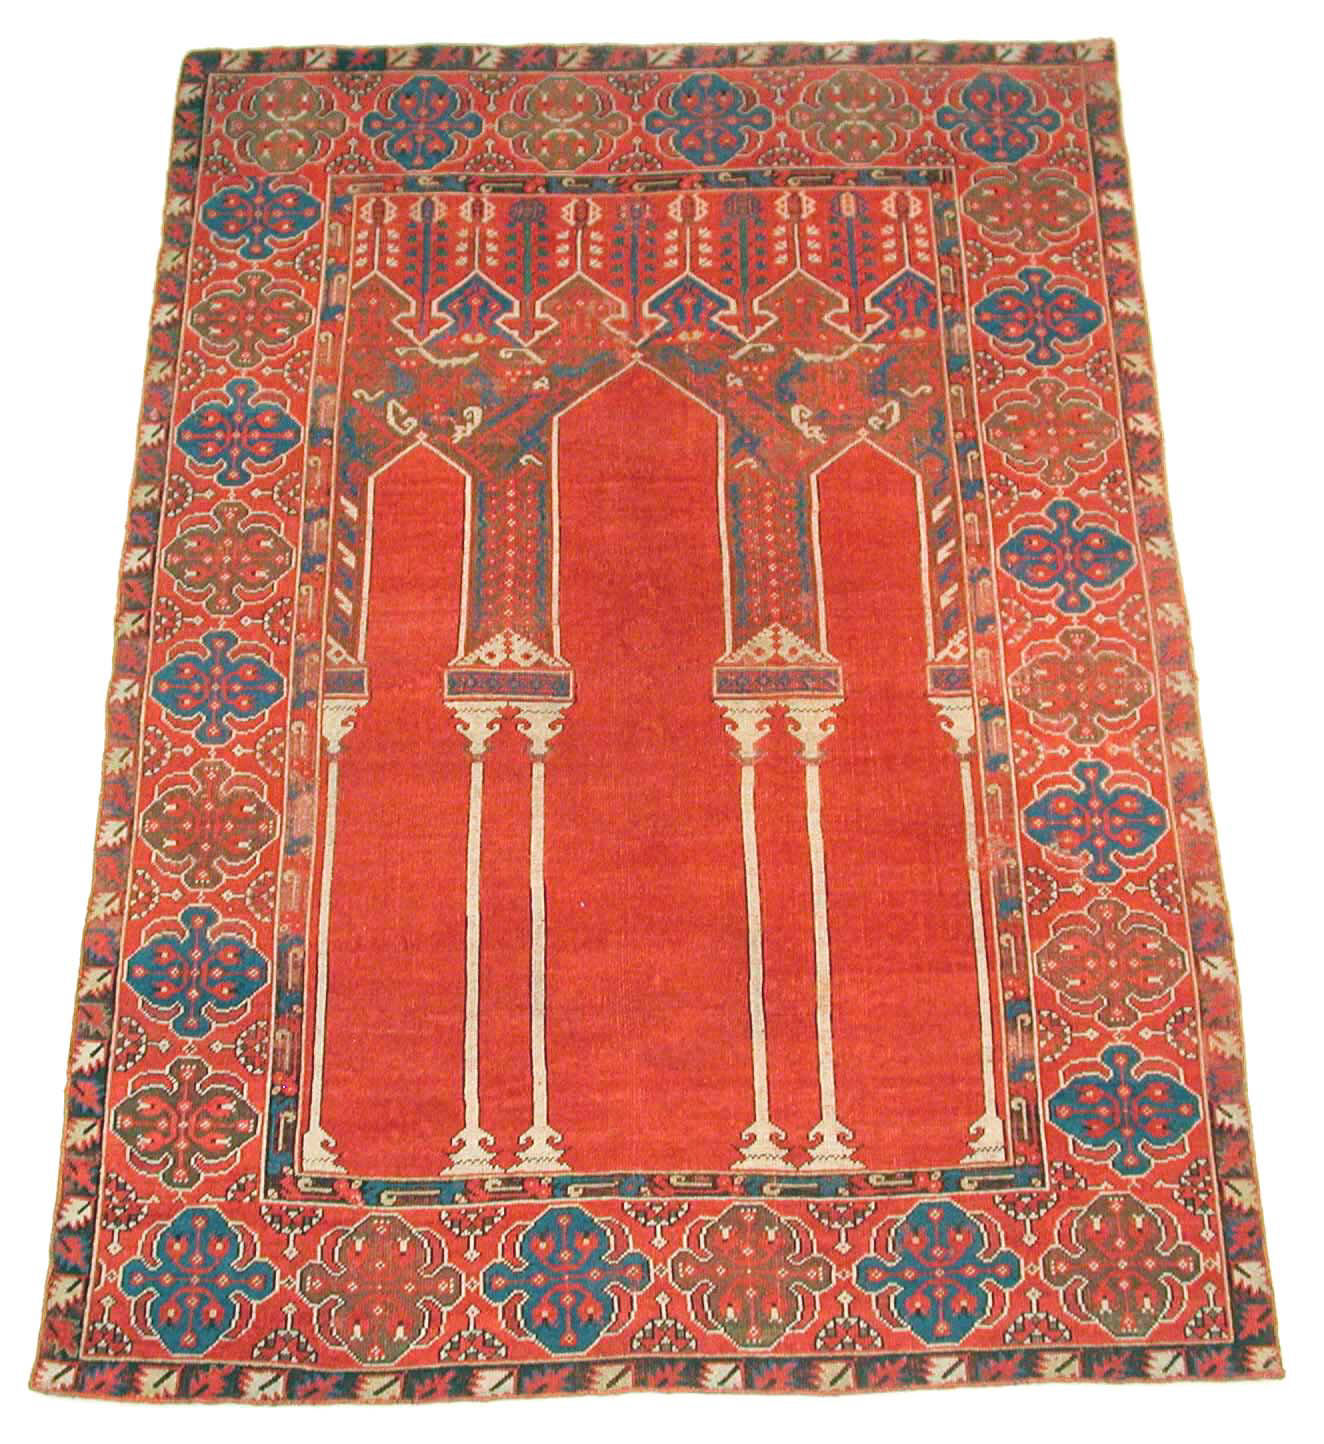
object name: carpet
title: Prayer Rug with Triple Arch Design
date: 1701-1800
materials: wool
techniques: pile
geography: turkey